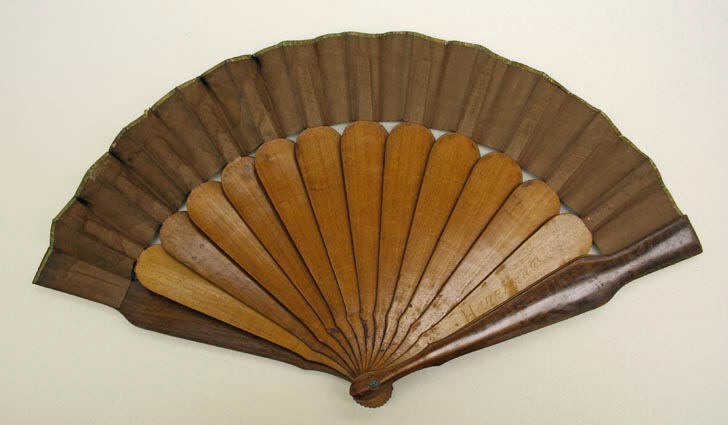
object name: fan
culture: american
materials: cotton, wood